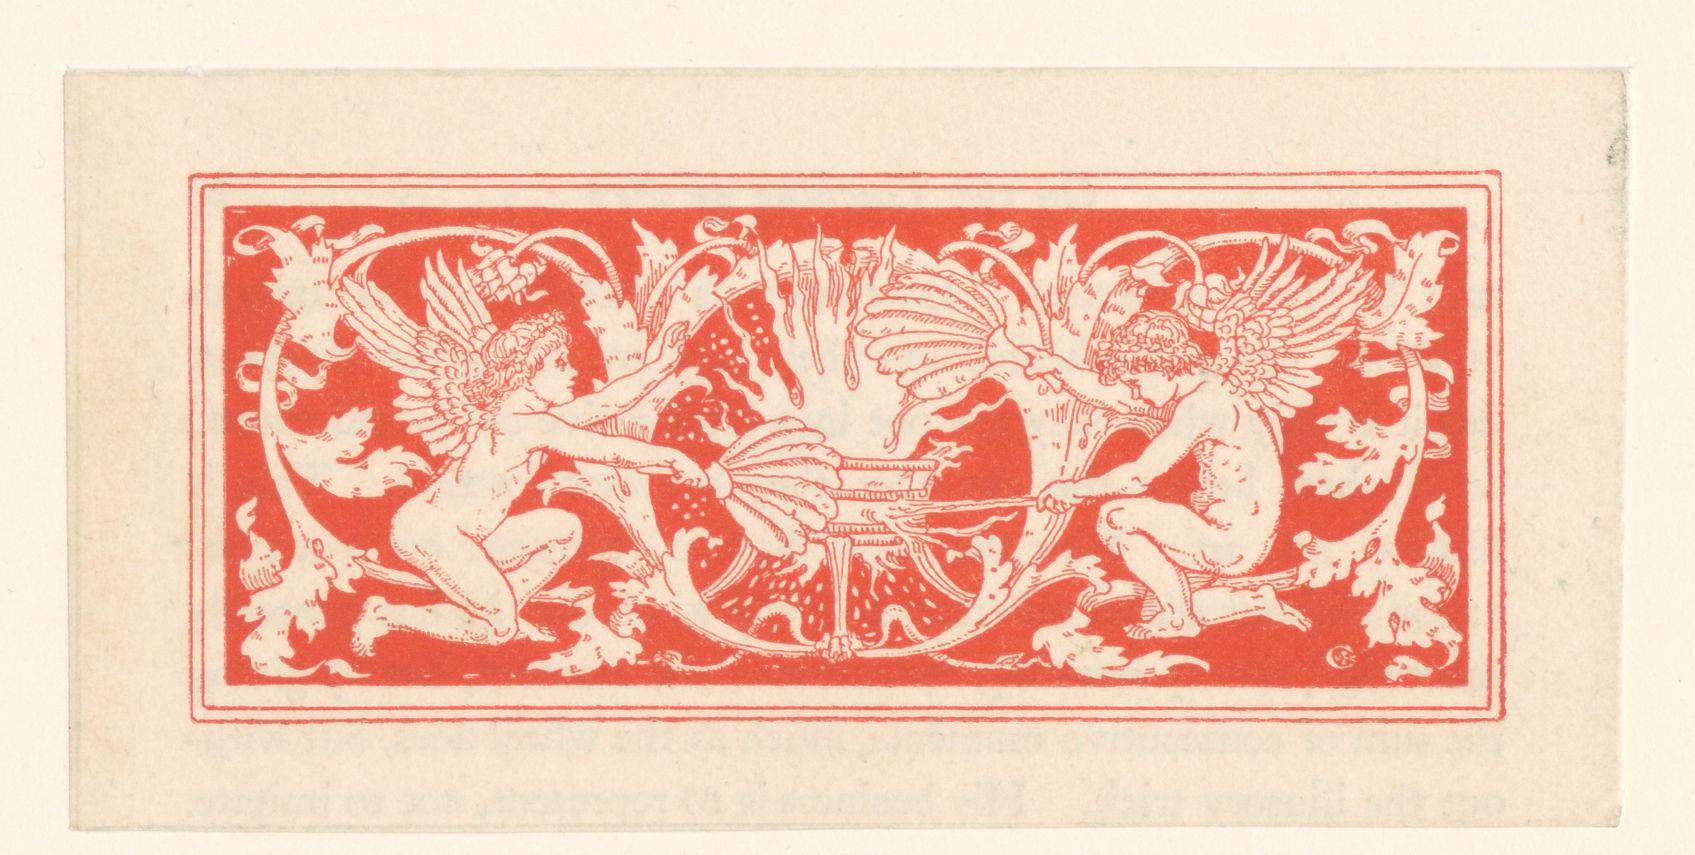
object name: print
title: Twee putti bij een vuurkorf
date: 1892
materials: paper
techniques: letterpress printing, engraving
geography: london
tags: stirring up a fire, foliage ~ ornament, cupids: 'amores', 'amoretti', 'putti'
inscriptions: collector's mark: Lugt 2228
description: Prent uit: Crane, Walter. The claims of decorative art. Londen: Lawrence & Bullen, 1892, p. 89-90.